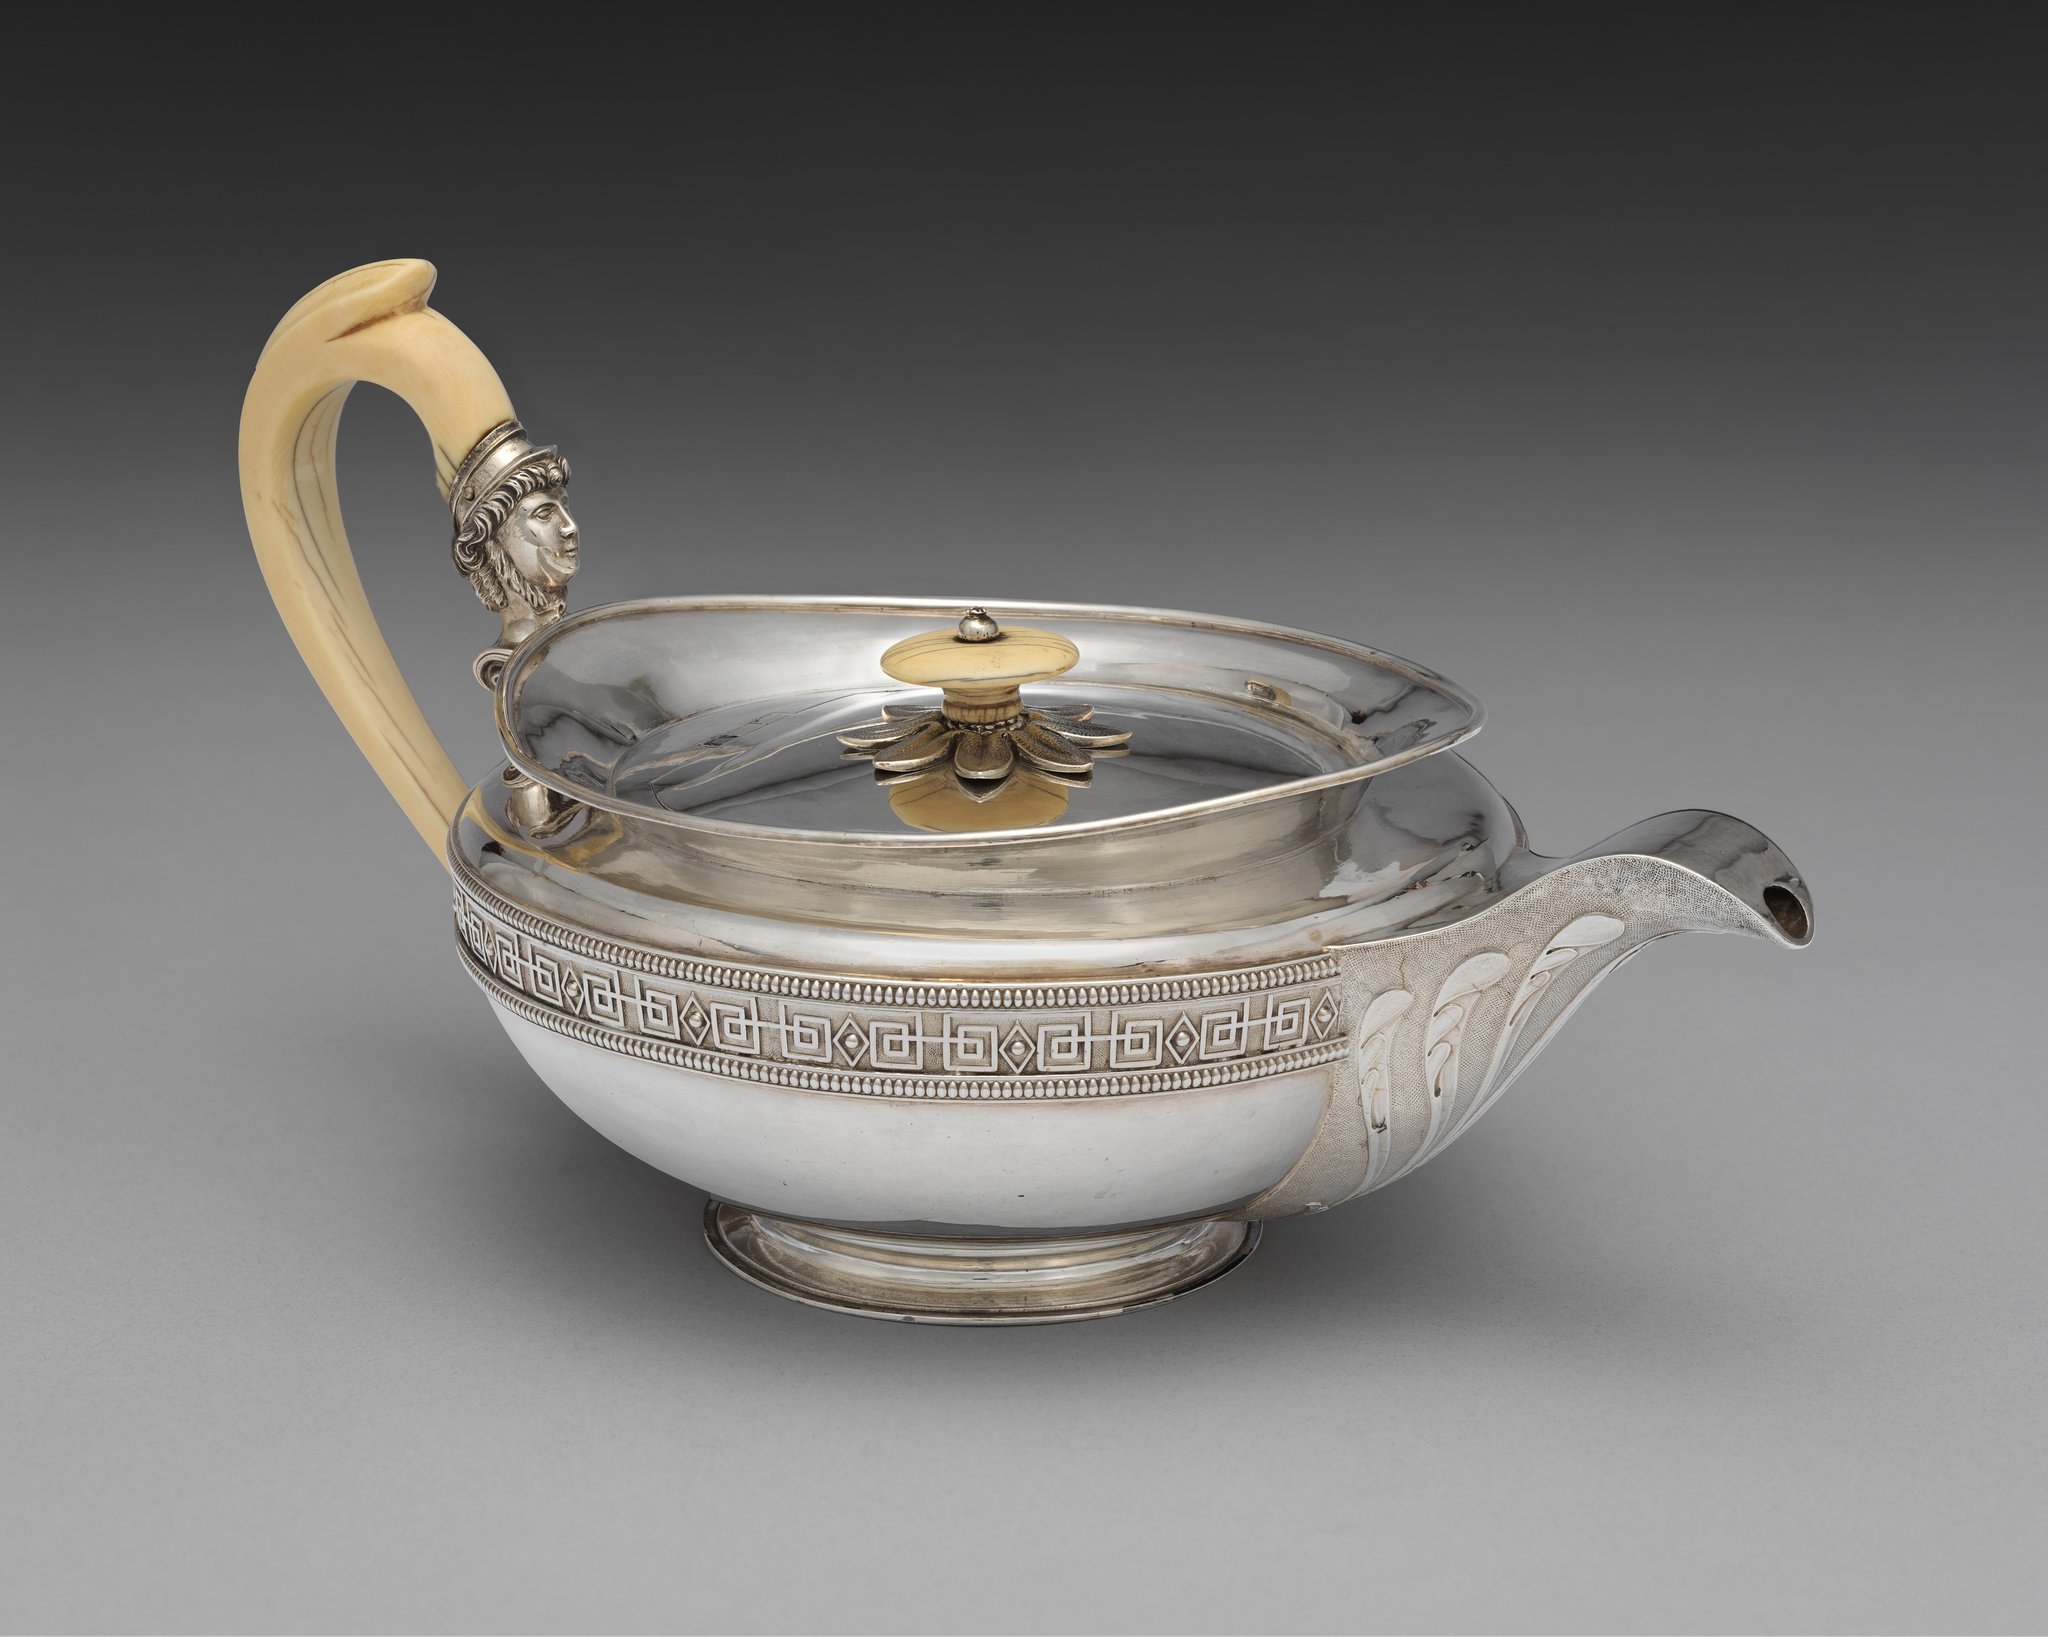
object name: teapot part of a service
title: Teapot (part of a service)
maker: digby scott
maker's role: maker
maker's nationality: british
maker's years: 1780-1880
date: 1805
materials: ivory, silver